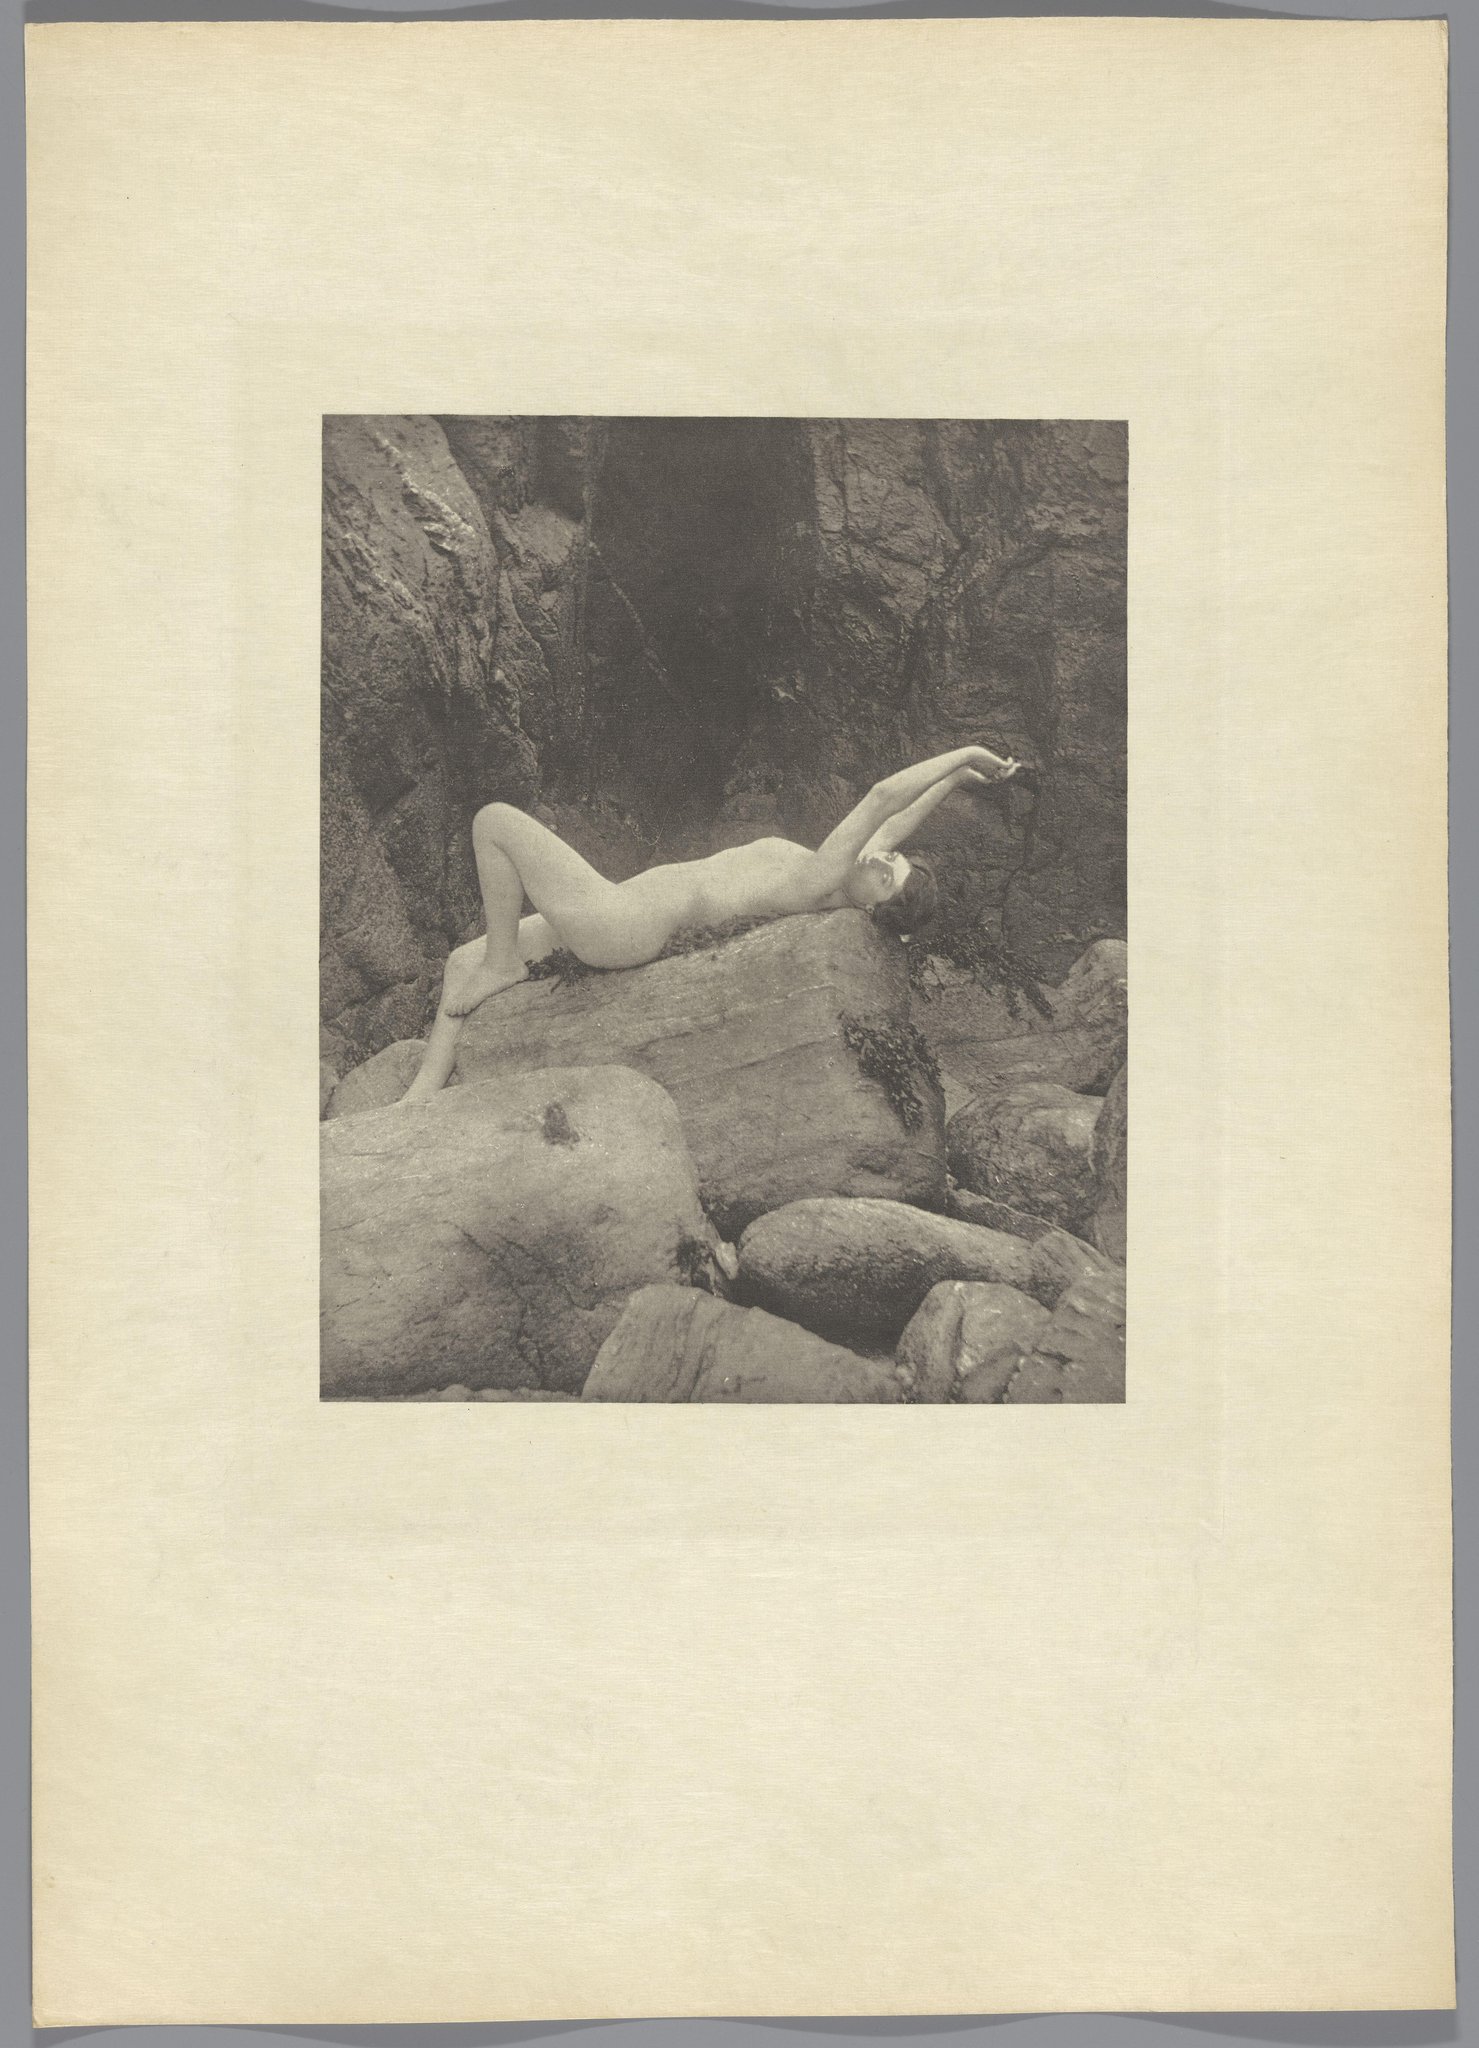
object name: photomechanical print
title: Vrouwelijk naakt op een rots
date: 1891-1896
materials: paper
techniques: photoaquatint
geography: paris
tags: arm raised upward, rock-formations, sirens (classical mythology), lying figure - aa - female human figure